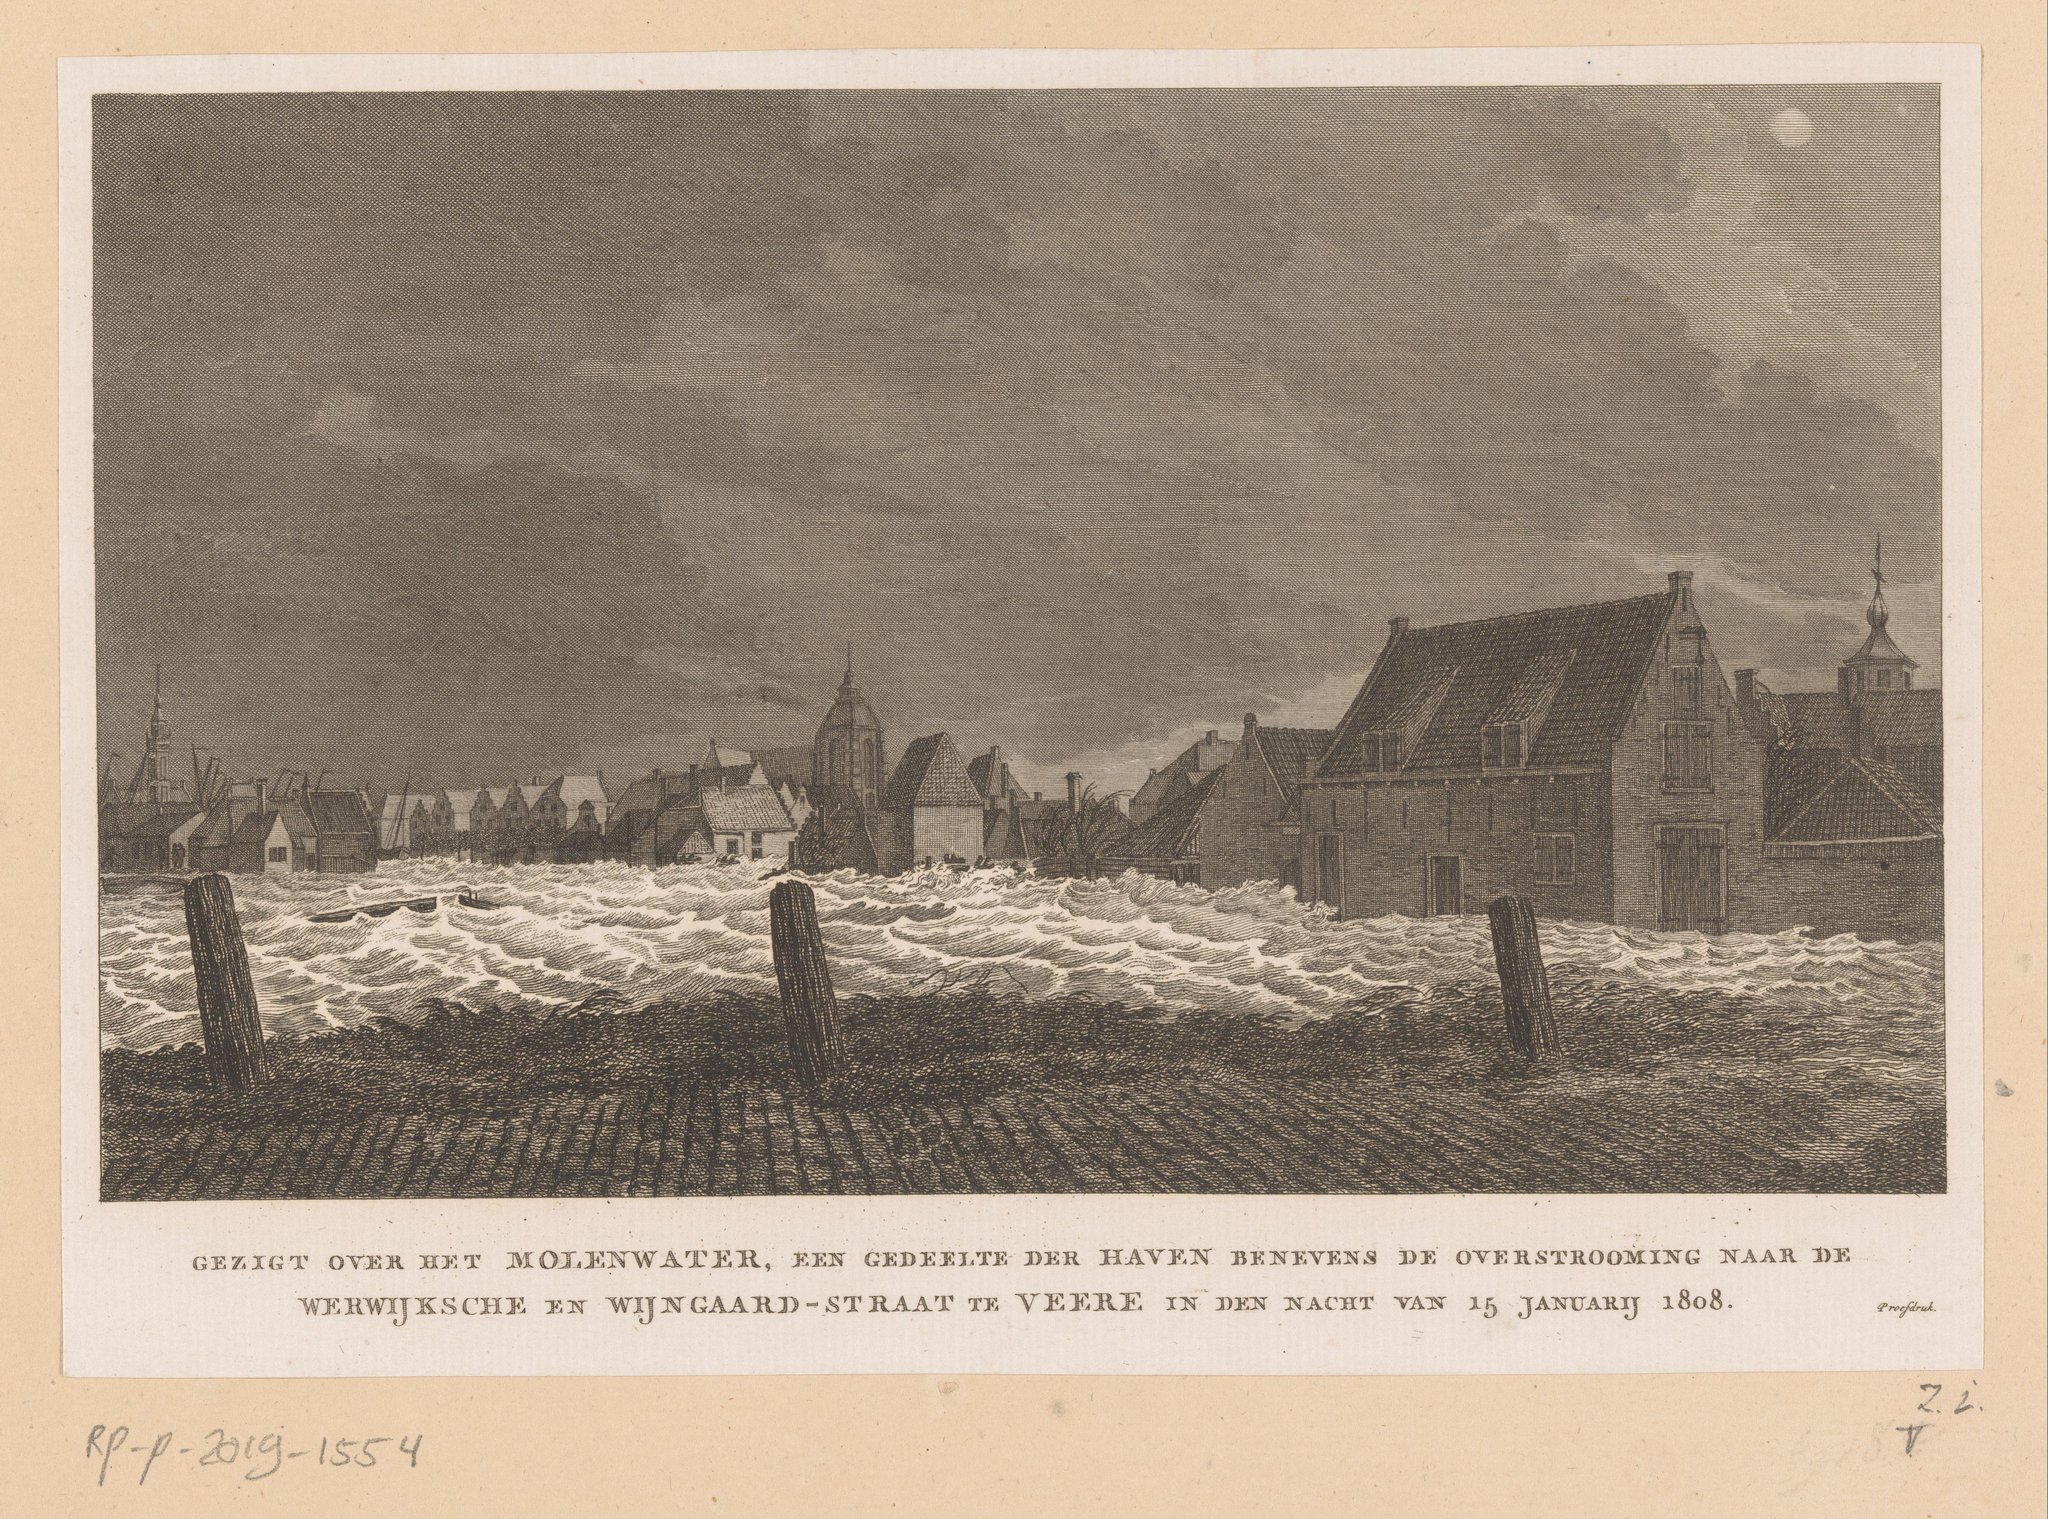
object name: book illustration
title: Overstroming bij het Molenwater en de haven te Veere, 1808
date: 1808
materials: paper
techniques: etching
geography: netherlands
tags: dike-break, flood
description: Prent uit: Hoek, S. van. Natuur- en geschiedkundige beschrijving van den verschrikkelijken watervloed tusschen den XIVden en XVden van Louwmaand des jaars 1808. Haarlem: Adriaan Pietersz. Loosjes, 1808, dl. 2, tussen p. 332 en 333.